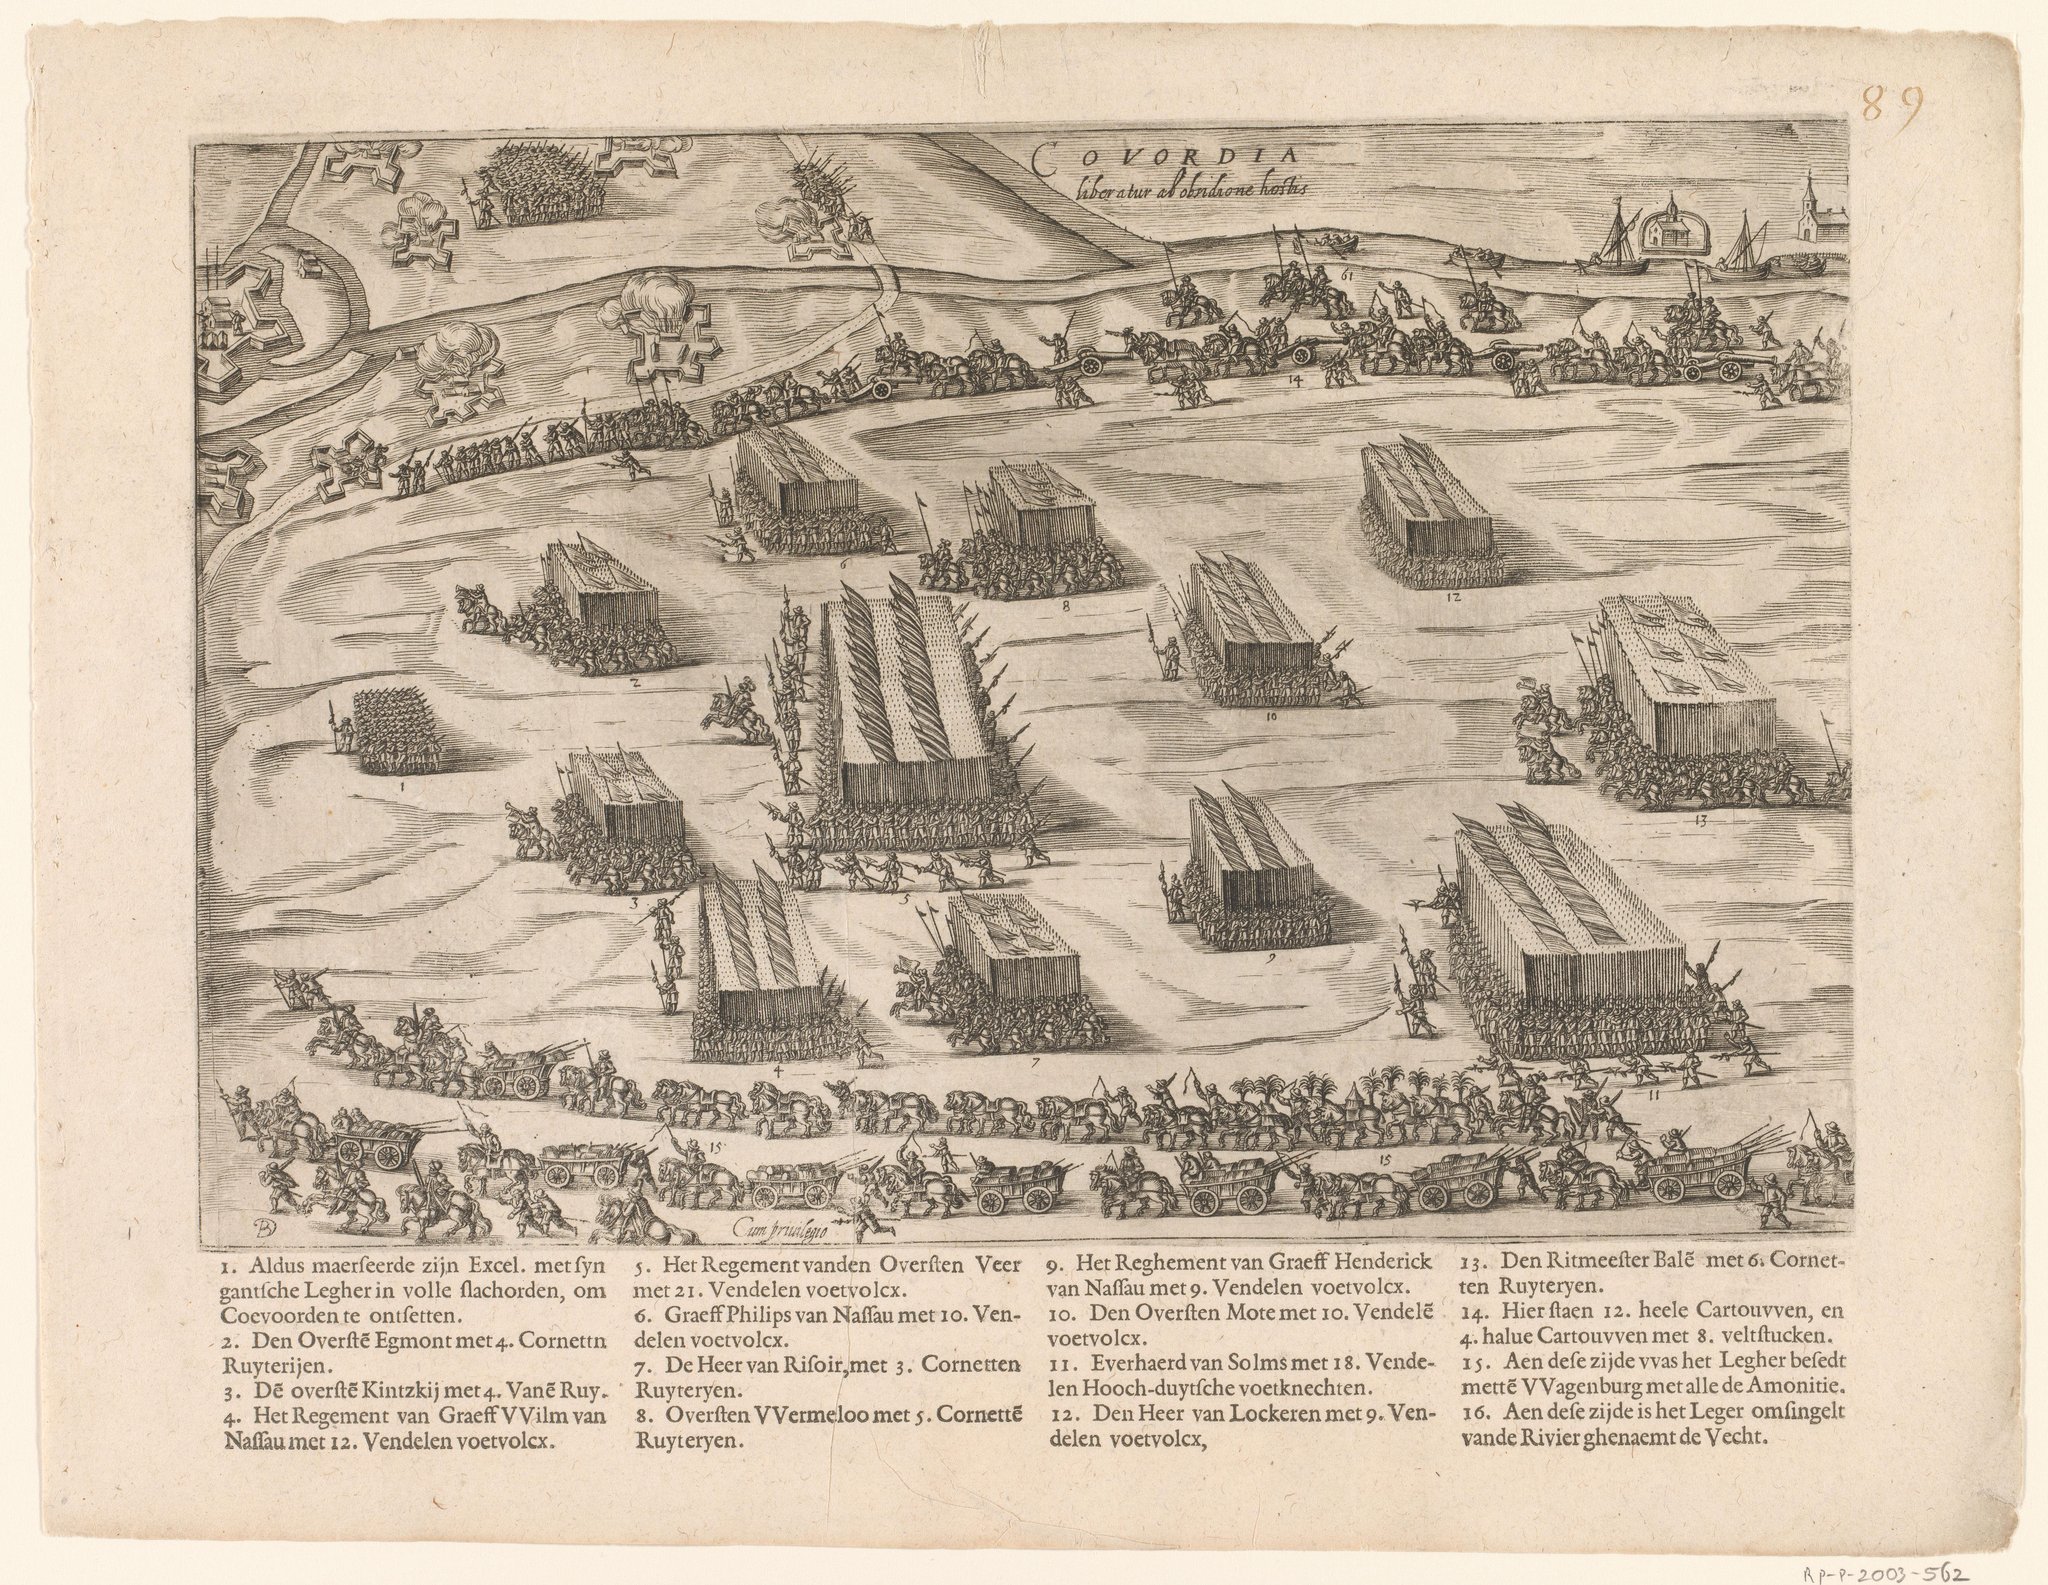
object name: area plan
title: Coevorden door Maurits ontzet, 1594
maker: bartholomeus willemsz. dolendo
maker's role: print maker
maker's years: 1560-1626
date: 1608-1610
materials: paper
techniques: engraving, letterpress printing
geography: northern netherlands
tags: the hague, maurice (prince of orange), troop movements, transportation, maps of cities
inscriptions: number: ‘89’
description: Coevorden, belegerd door Spaanse troepen onder Verdugo, wordt door het Staatse leger onder prins Maurits ontzet, 7 mei 1594. Het leger trekt in marsorde op naar Coevorden. Apart onder de plaat gedrukt de legenda 1-16 in het Nederlands. Onderdeel van de verzameling kaarten genomen uit een latere editie van: Descrittione di tutti i Paesi Bassi van Lodovico Guicciardini.